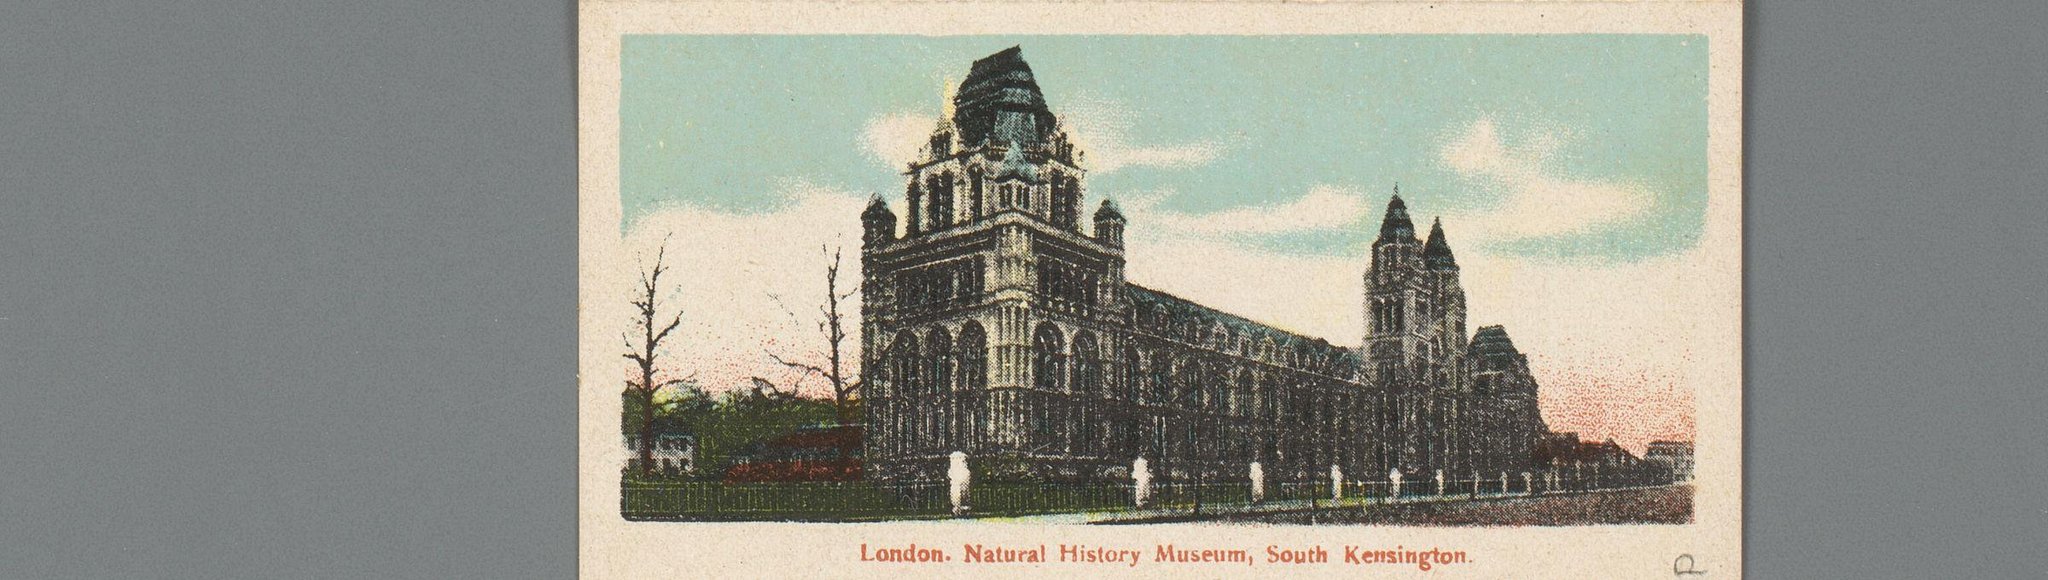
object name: album leaf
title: London. Natural History Museum, South Kensington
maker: Anonymous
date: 1888-1914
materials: paper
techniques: autotype, chromophotolithography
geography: london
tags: permanent exhibition, museum, london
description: Deze prent maakt deel uit van een album.